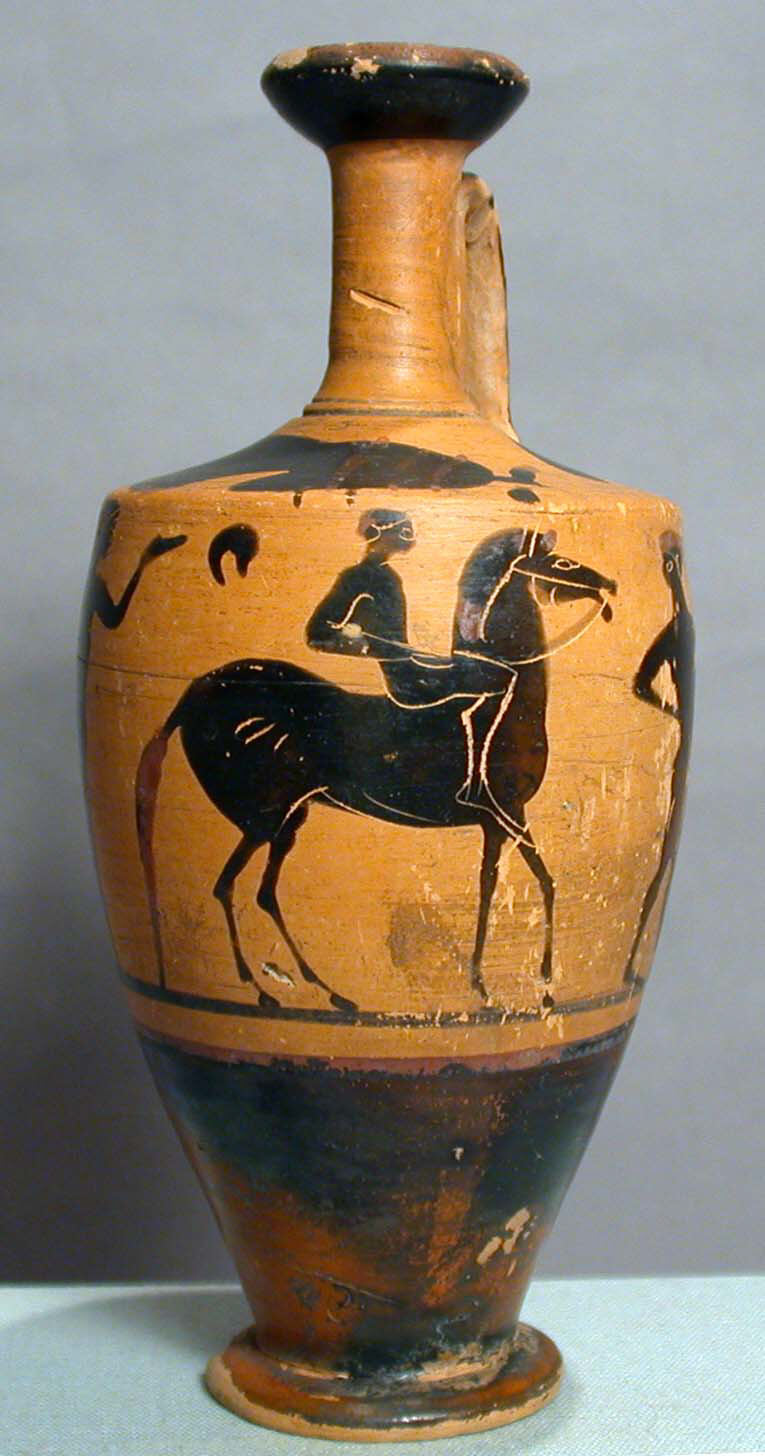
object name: lekythos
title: Terracotta lekythos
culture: greek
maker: attributed to the cock painter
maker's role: artist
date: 525-501 BCE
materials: terracotta